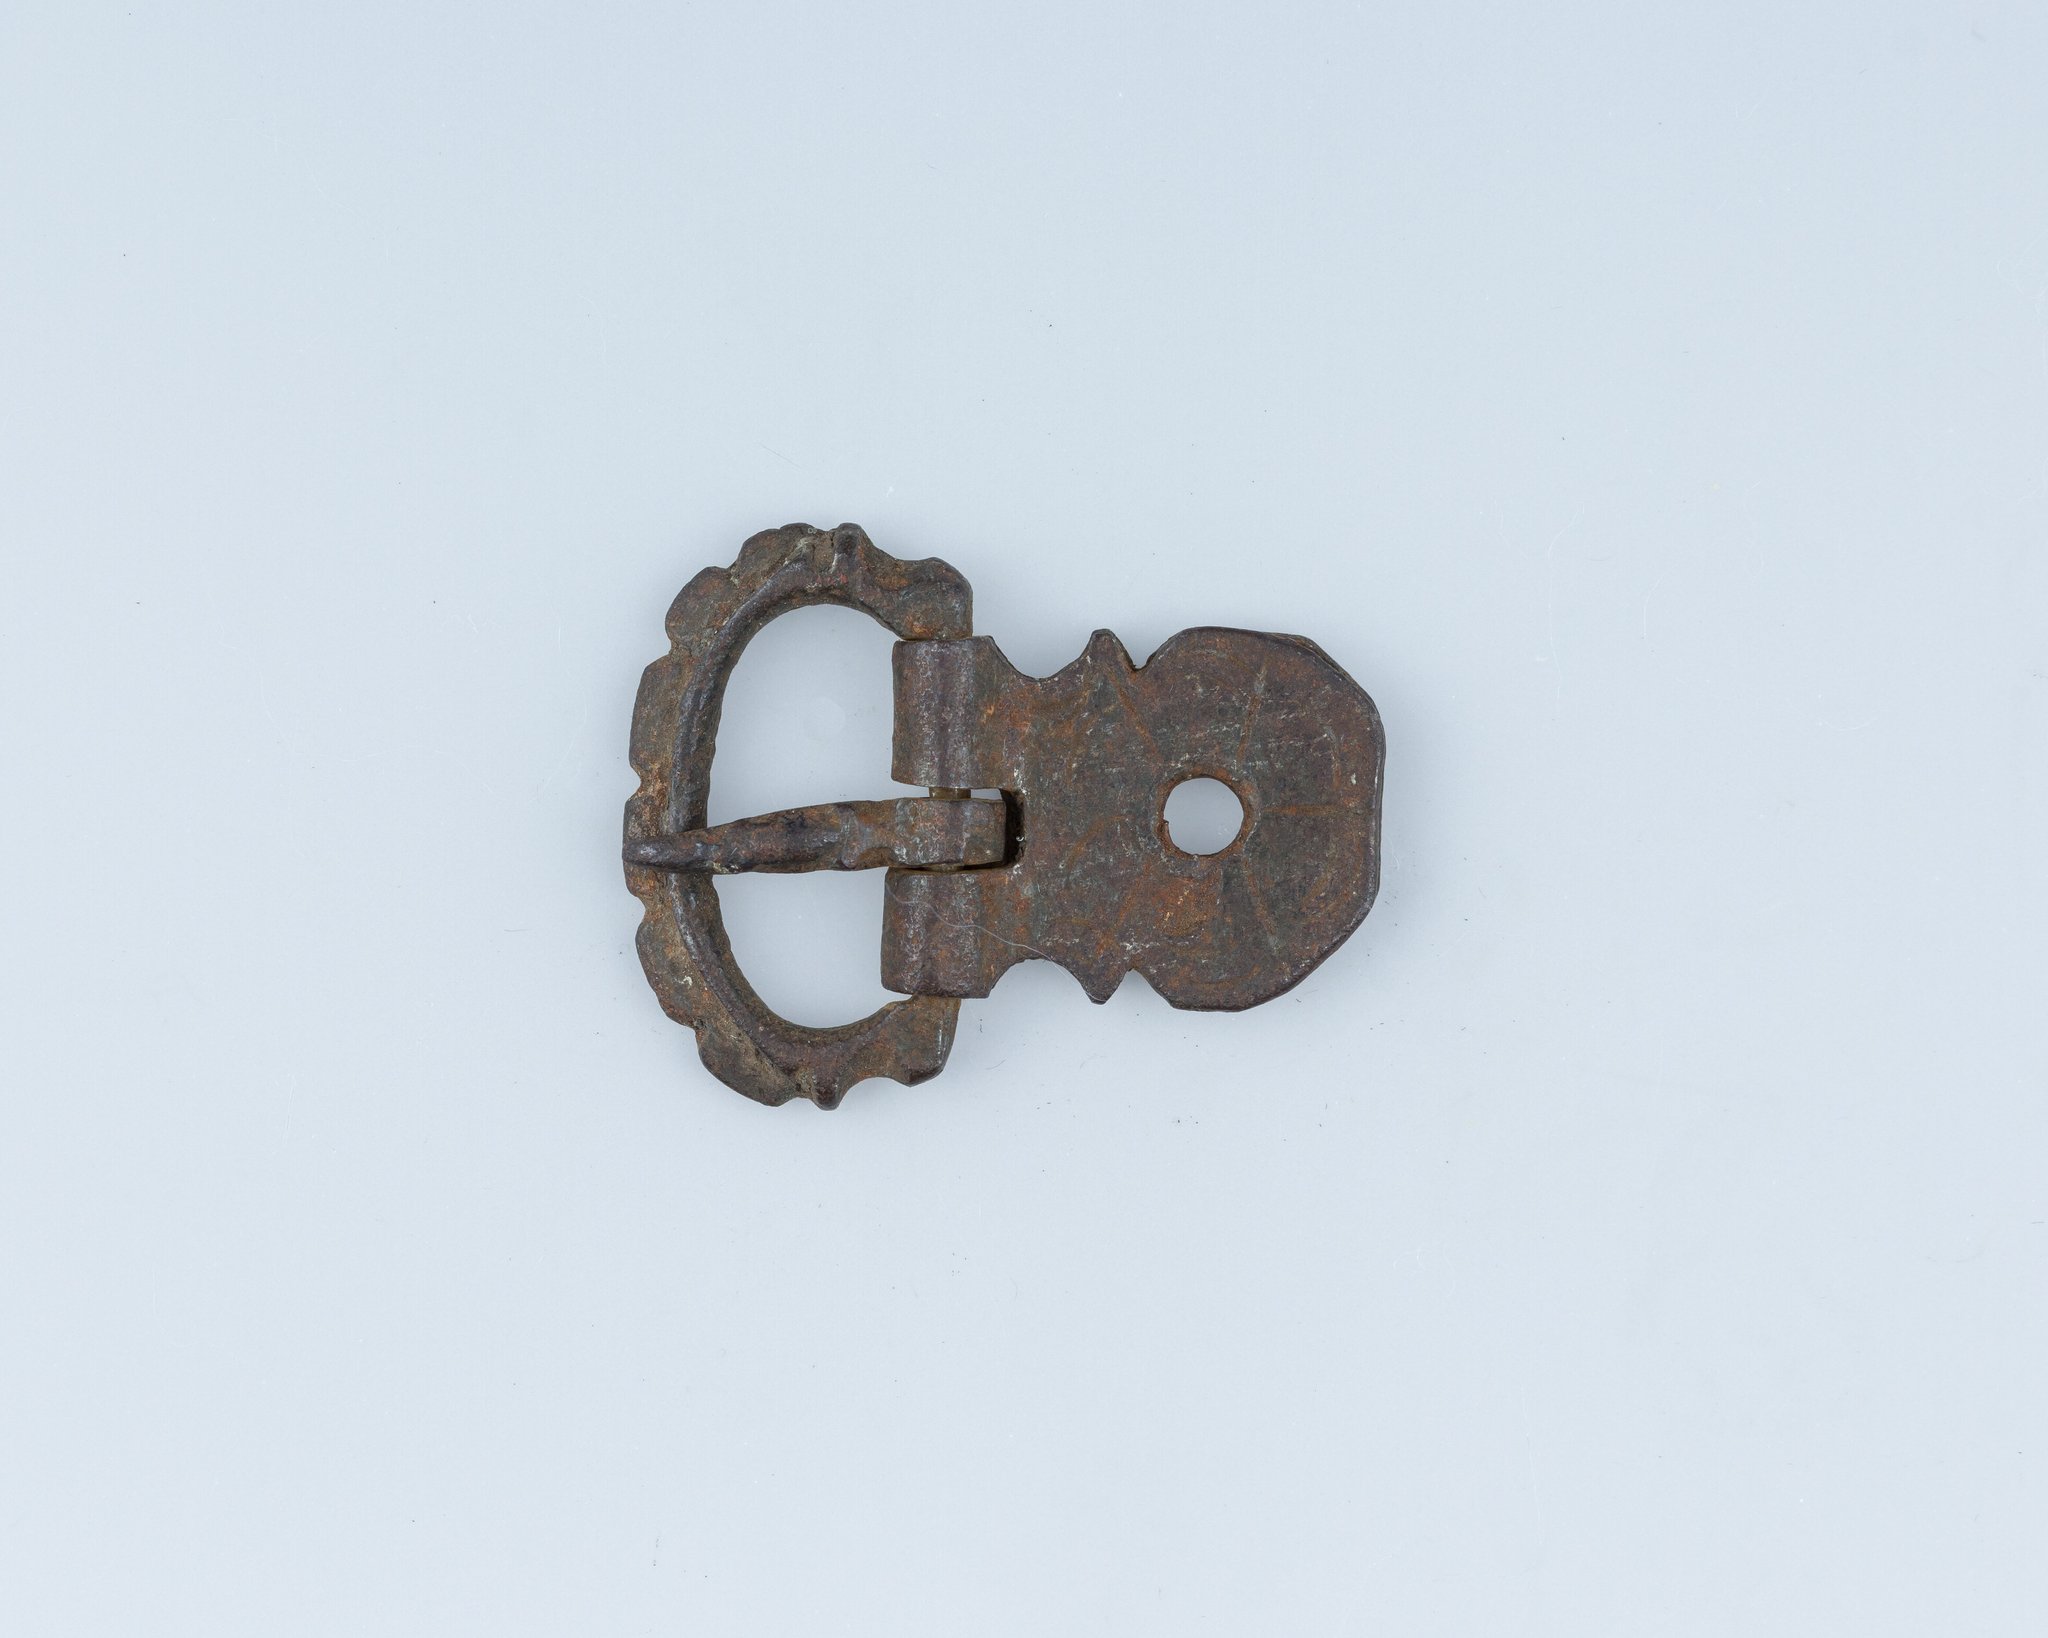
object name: buckle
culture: german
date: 1467-1500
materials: steel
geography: germany